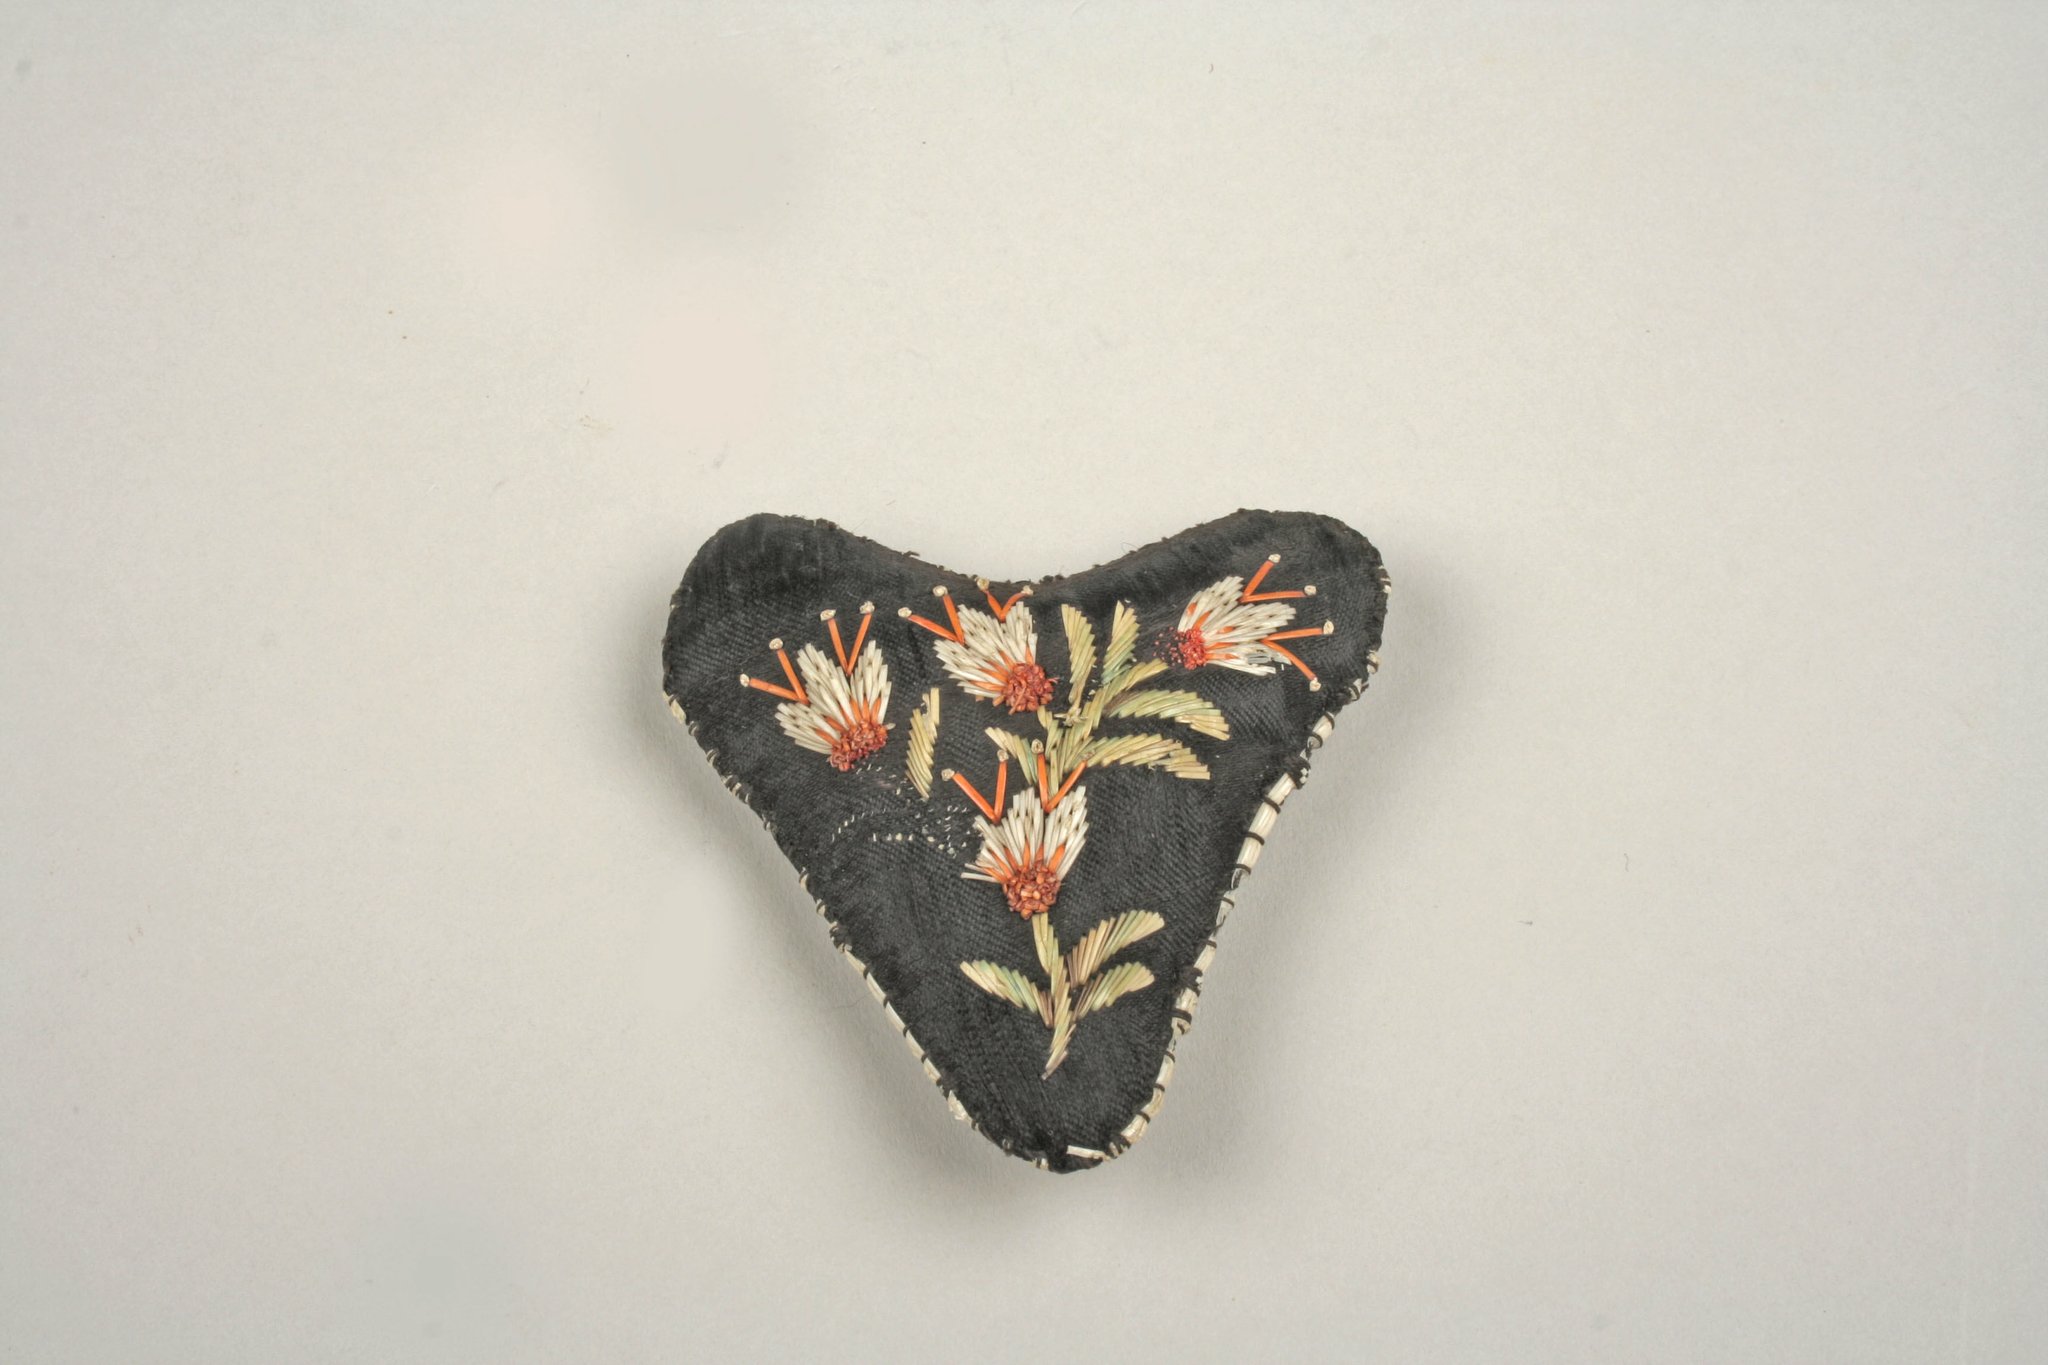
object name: pincushion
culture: huron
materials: textile, silk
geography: canada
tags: flowers